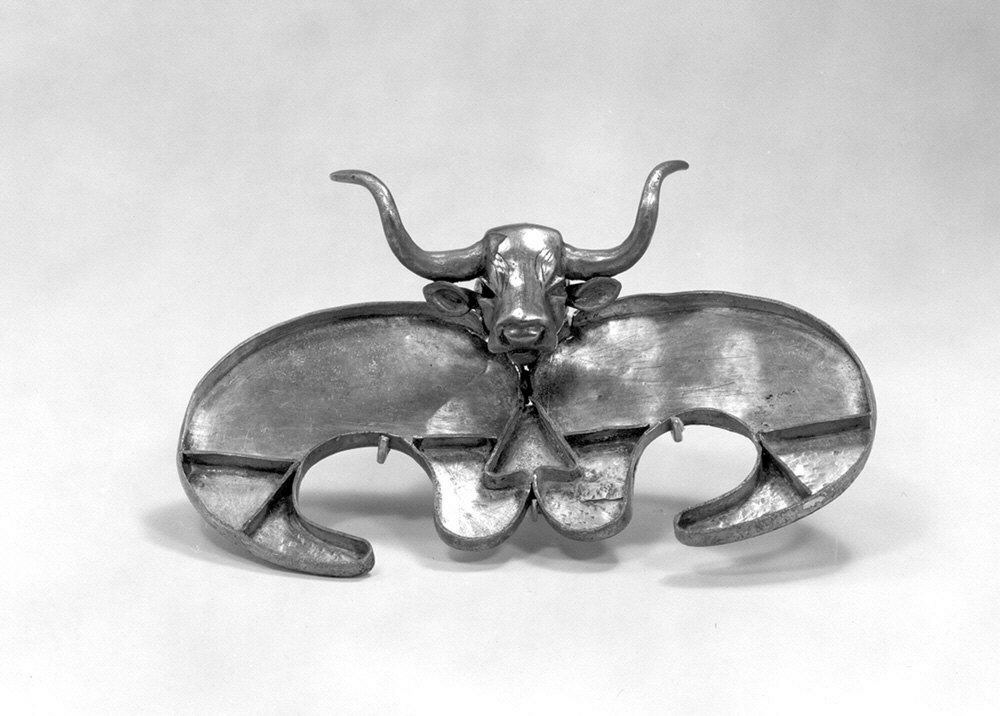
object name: pendant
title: Compartmented pendant with a bull's head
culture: proto-elamite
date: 3100-2900 BCE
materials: silver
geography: iran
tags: bulls